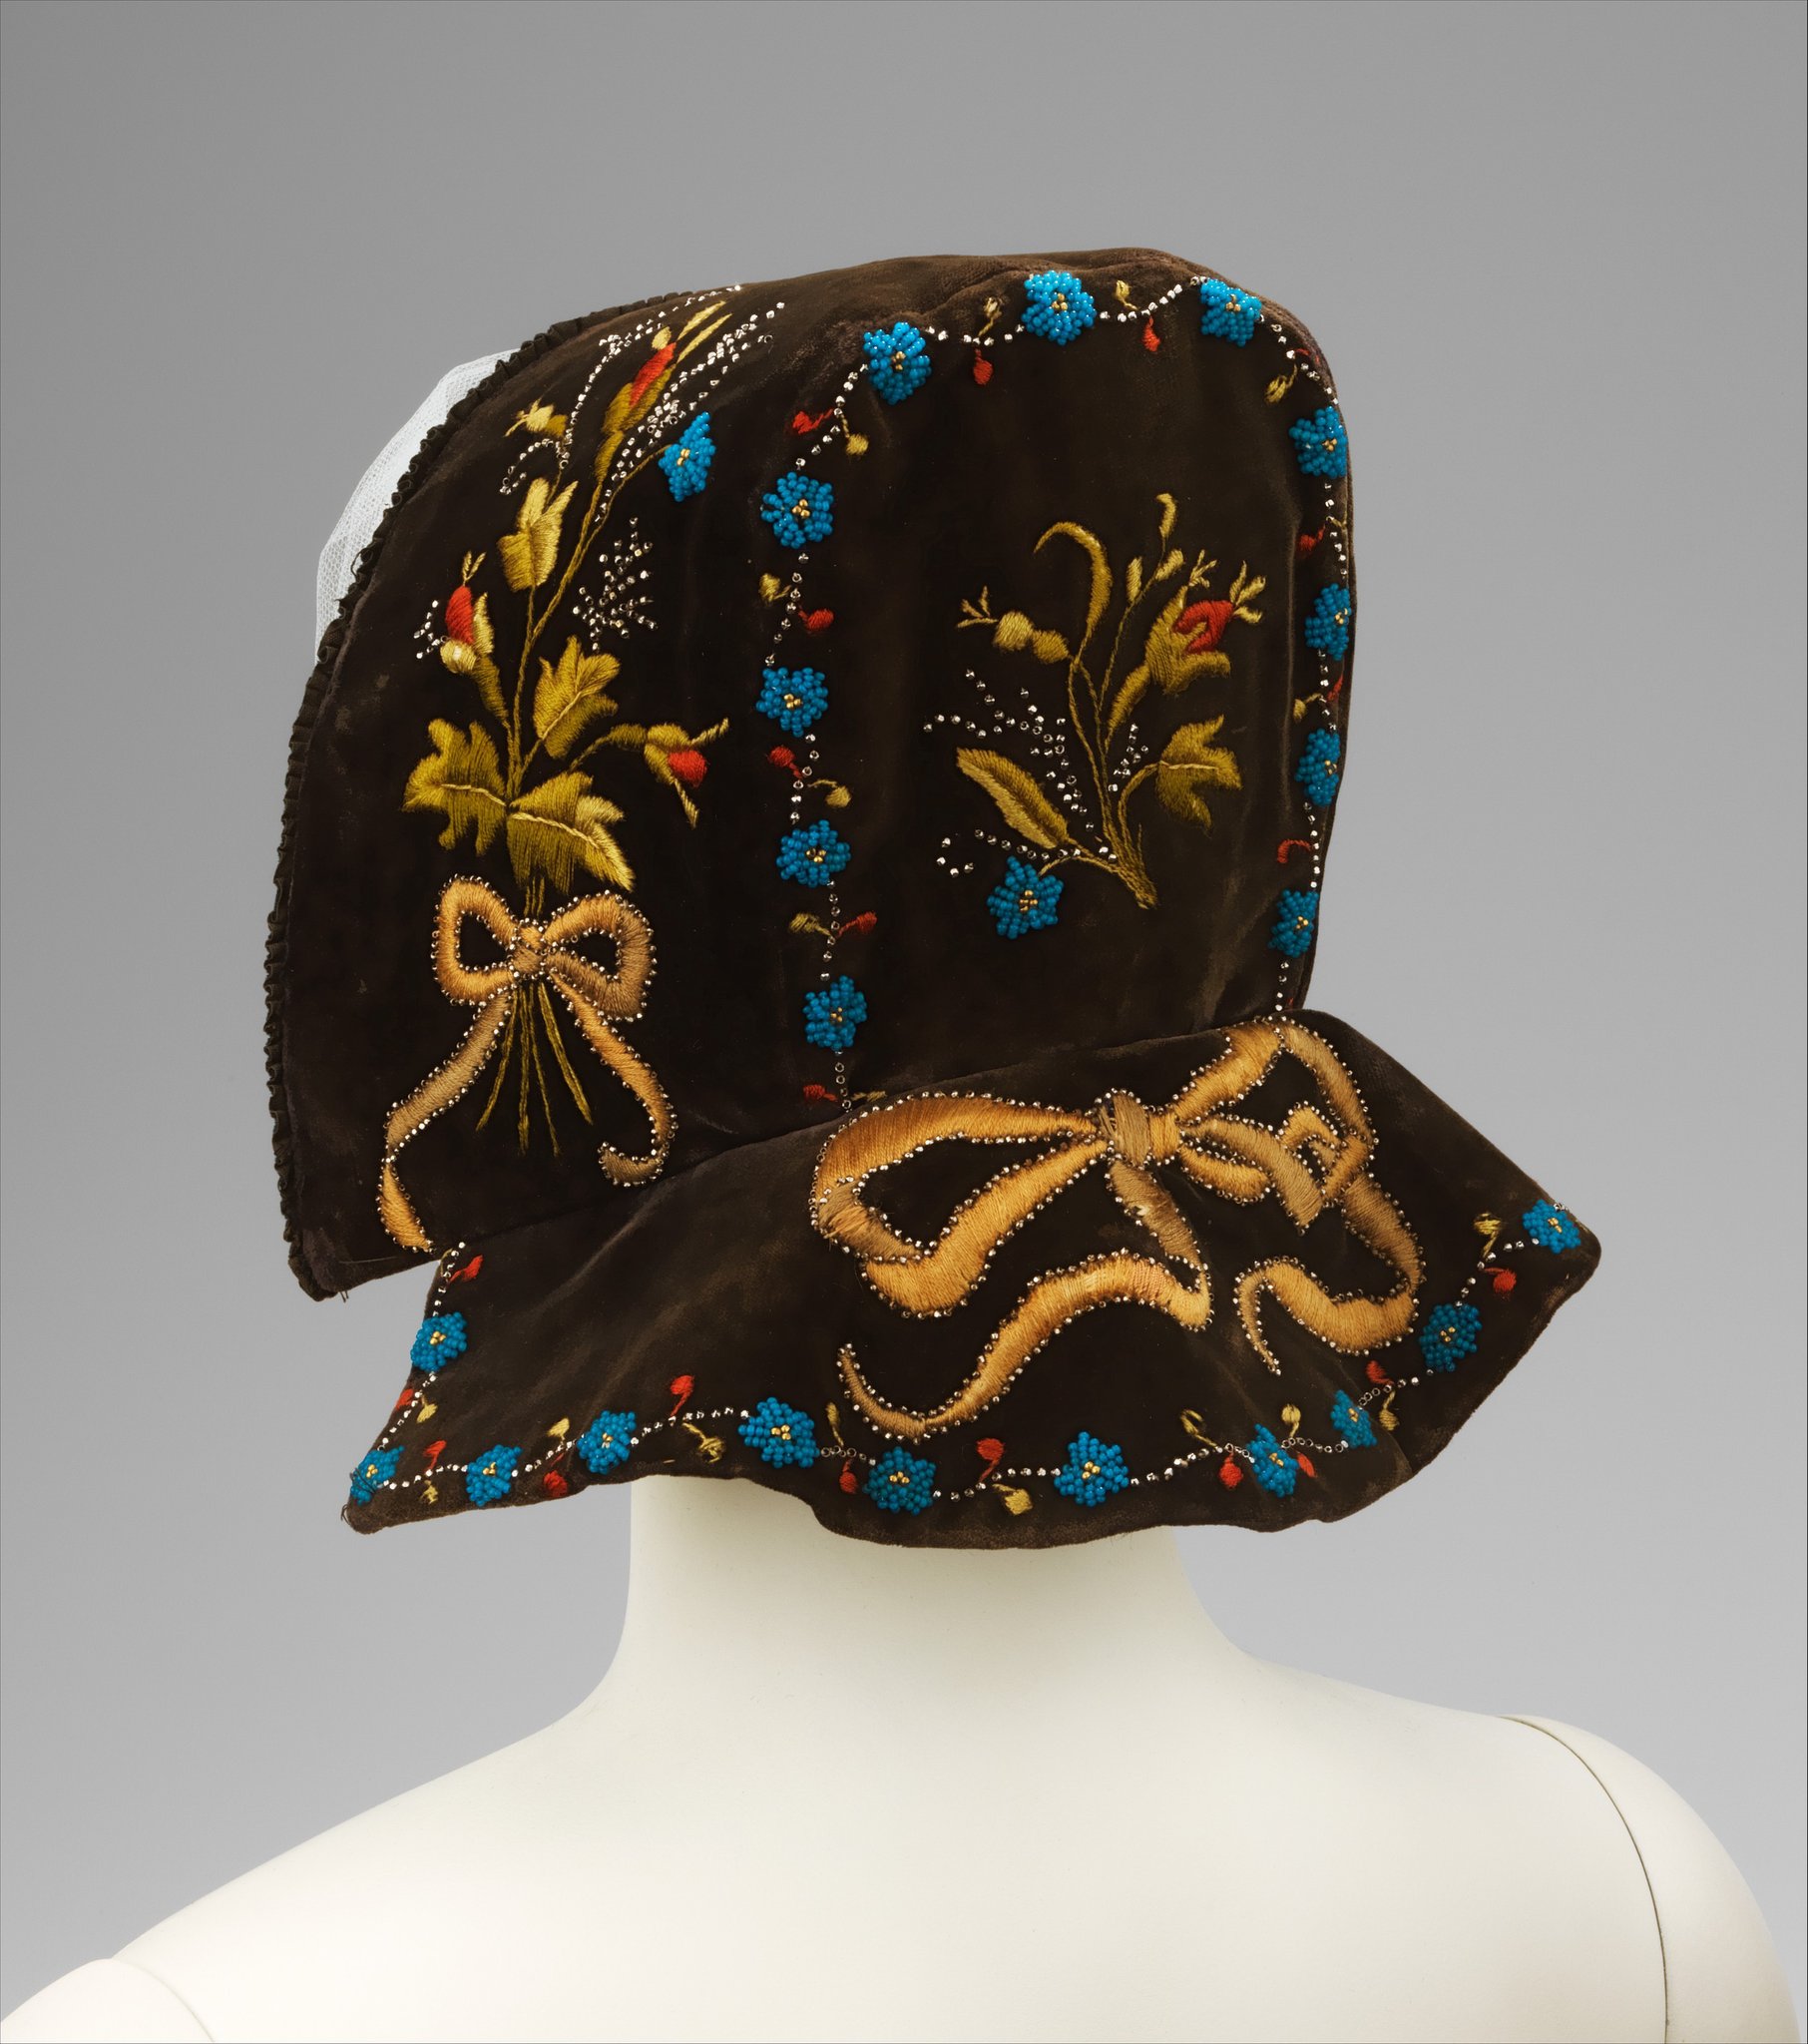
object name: bonnet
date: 1876-1900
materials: glass, metal, silk